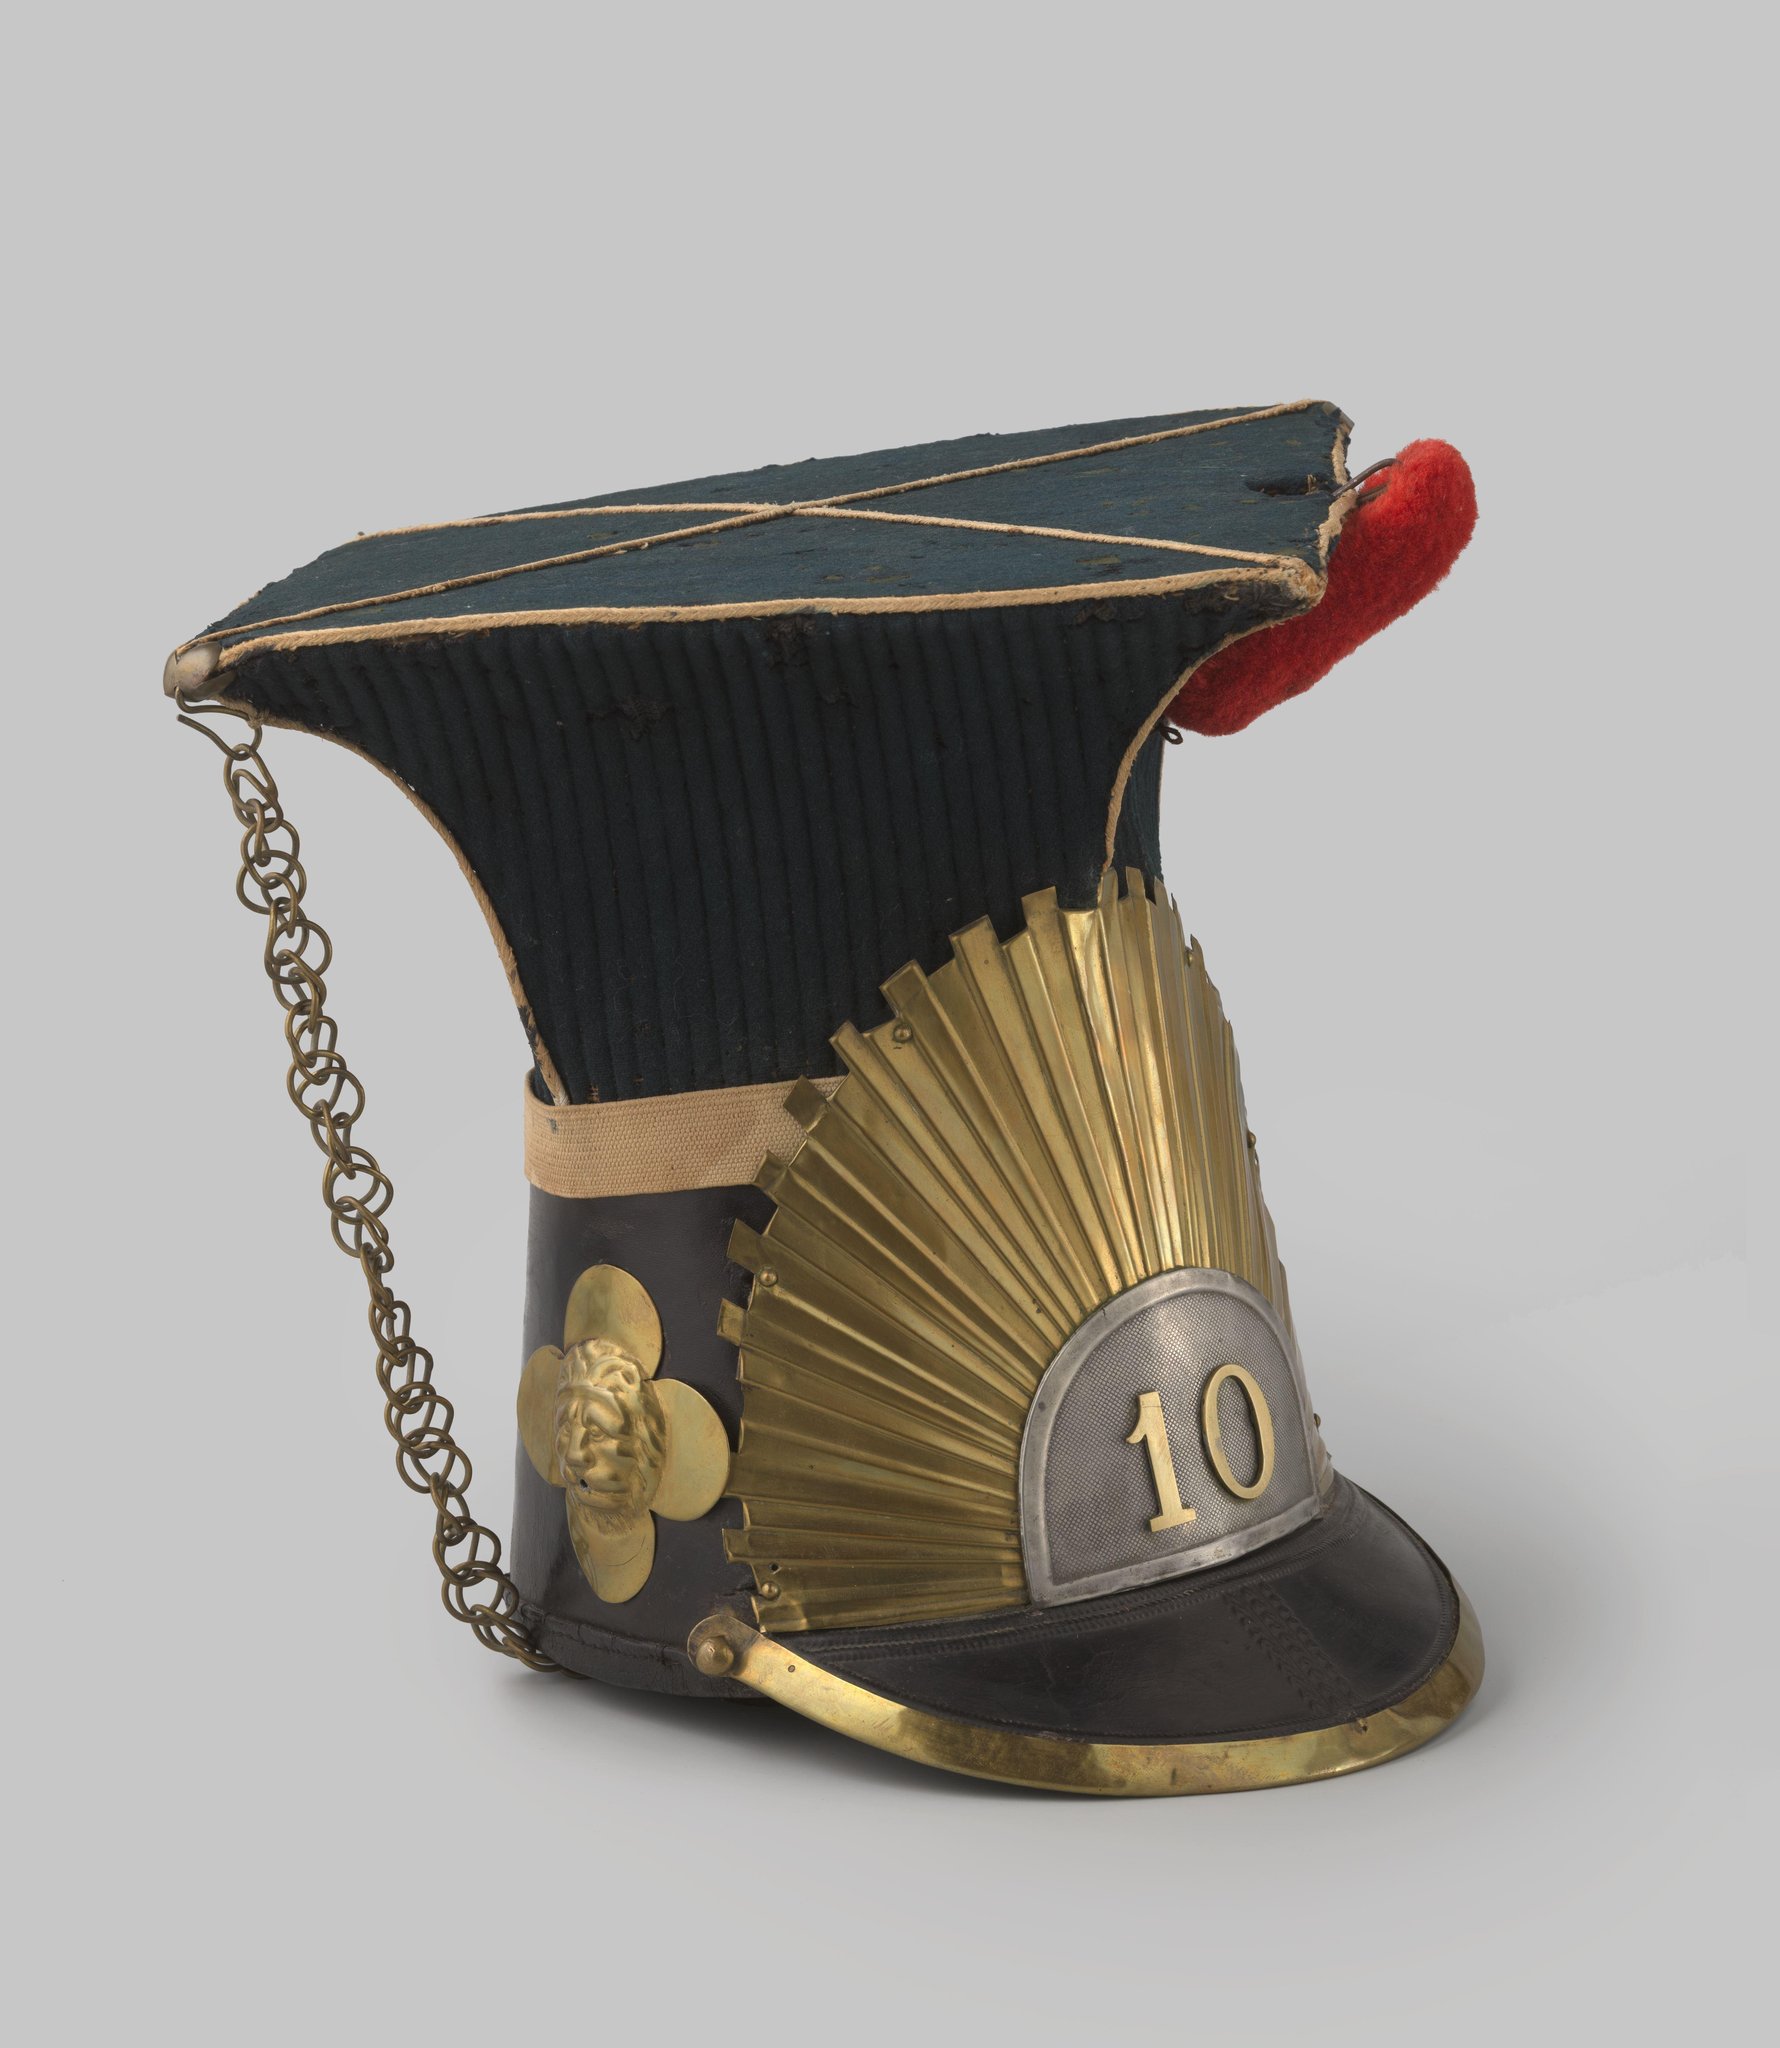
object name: cap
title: Chapzka van het 10e Regiment Lansiers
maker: Anonymous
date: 1824-1850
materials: textile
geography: netherlands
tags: mechelen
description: Een chapzka van groen laken met witte biezen, met een frontplaat waarop het getal 10, zijnde het primiteve model van het hoofddeksel van het 10e regiment dat in 1824 in Mechelen werd opgericht. Aan de achterzijde gescheurd, pompoen, snoeren en stormketting ontbreken.